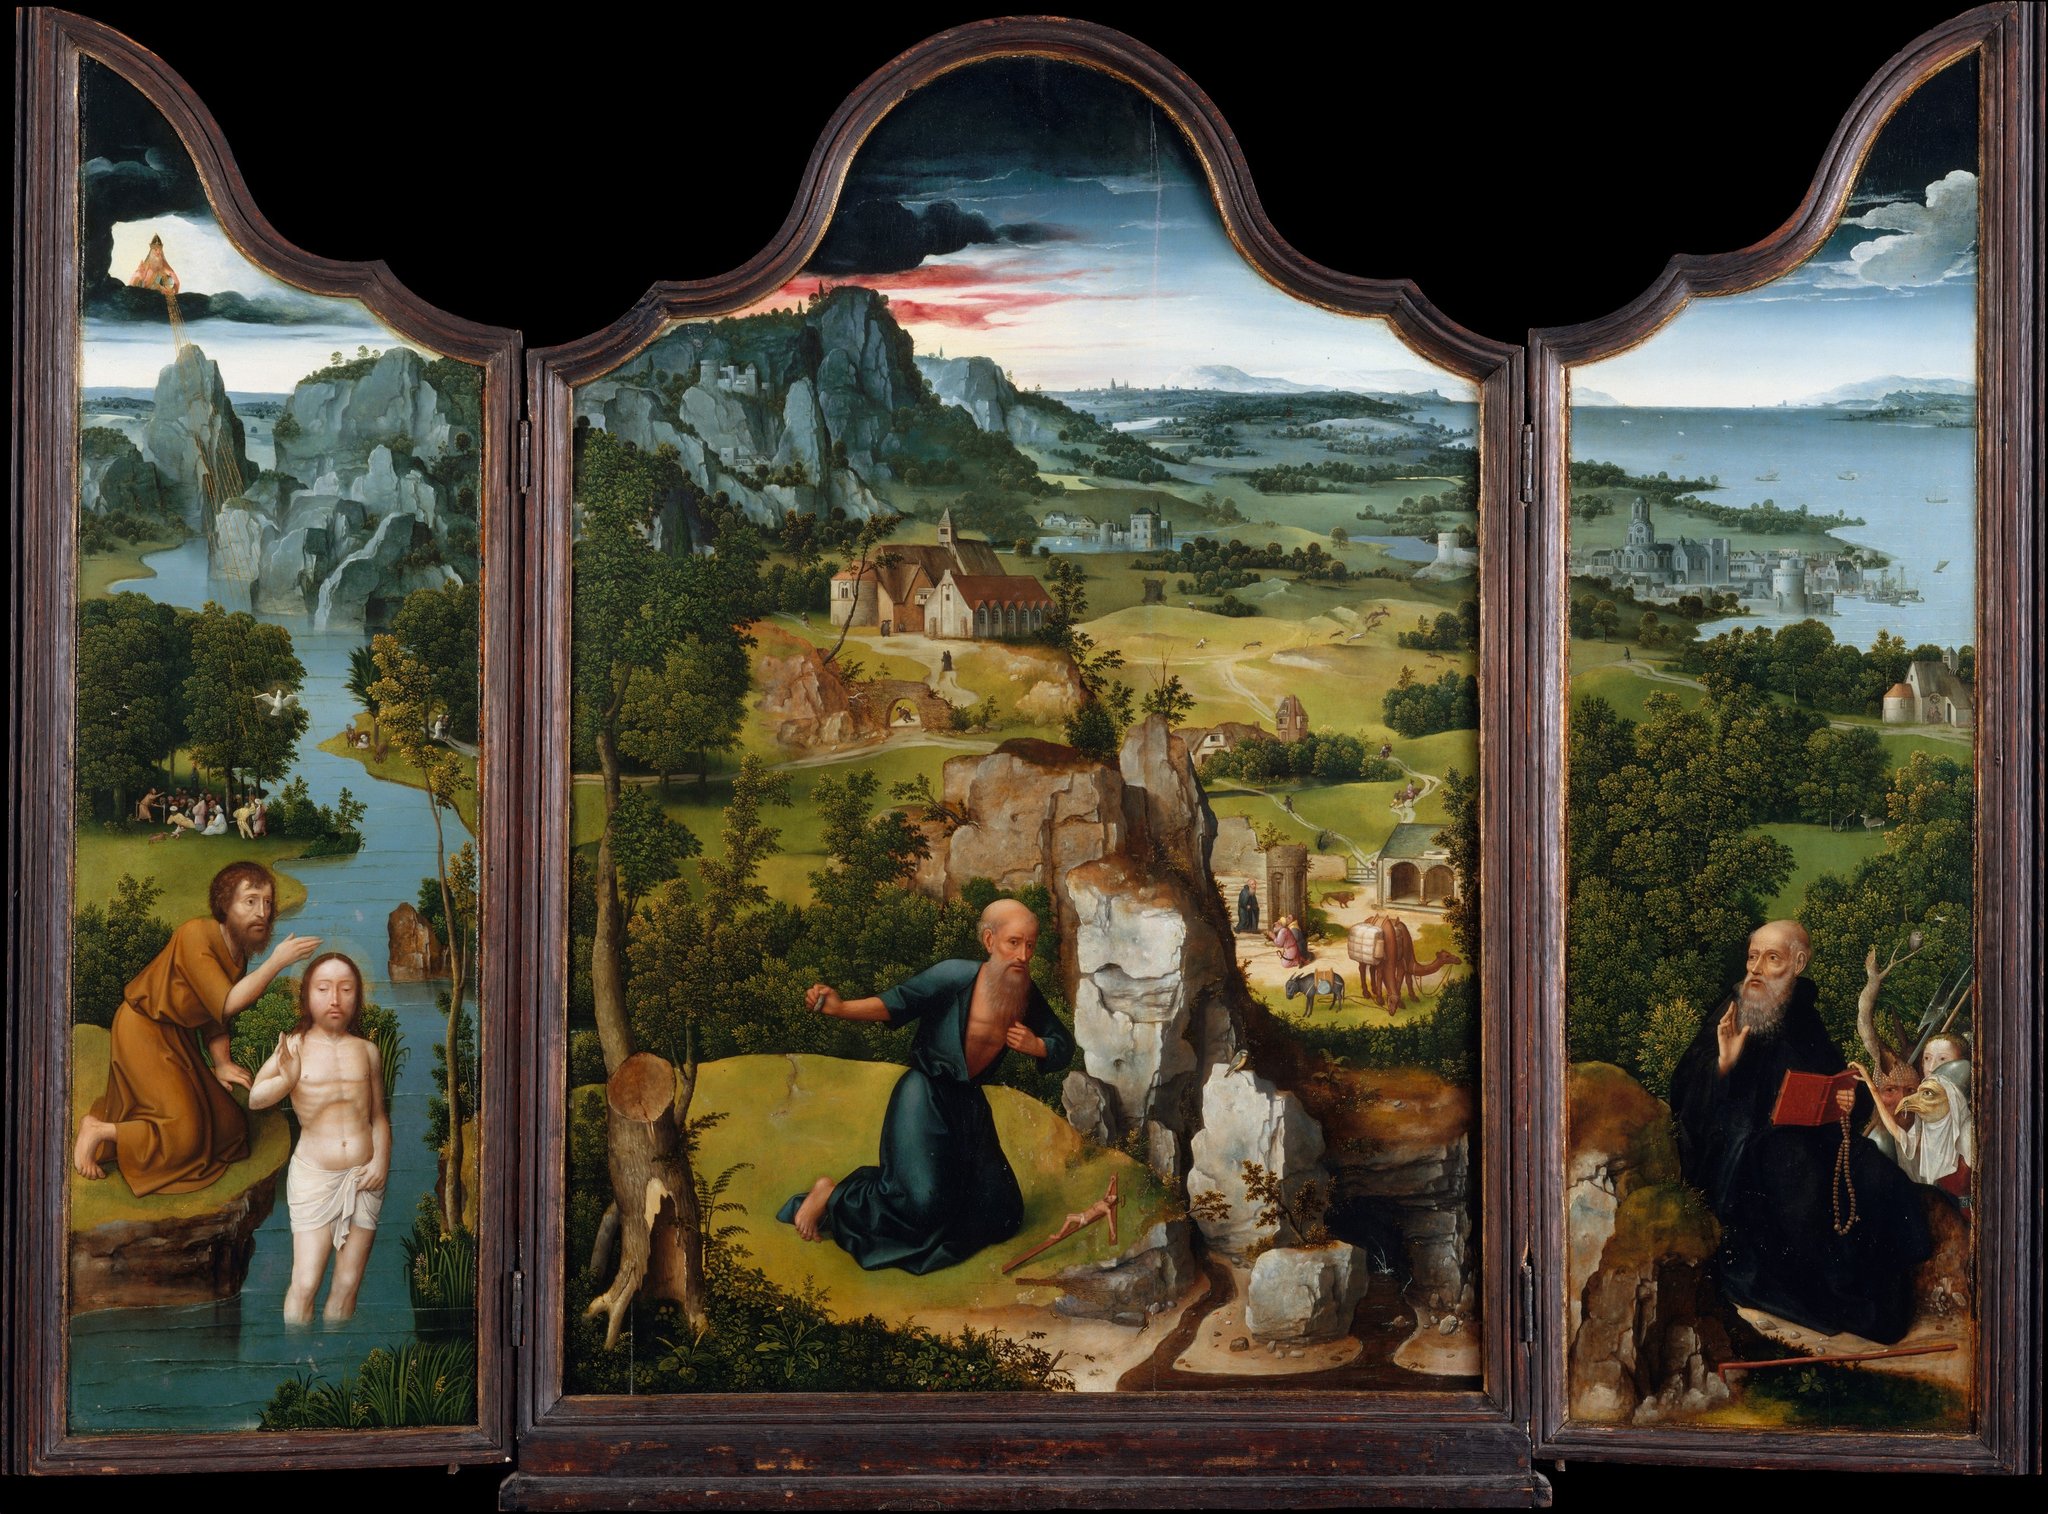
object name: painting, triptych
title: The Penitence of Saint Jerome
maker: joachim patinir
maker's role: artist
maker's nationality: netherlandish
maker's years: 1515-1524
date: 1515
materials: oil, wood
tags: landscapes,saint jerome,saint john the baptist,jesus,baptism of christ